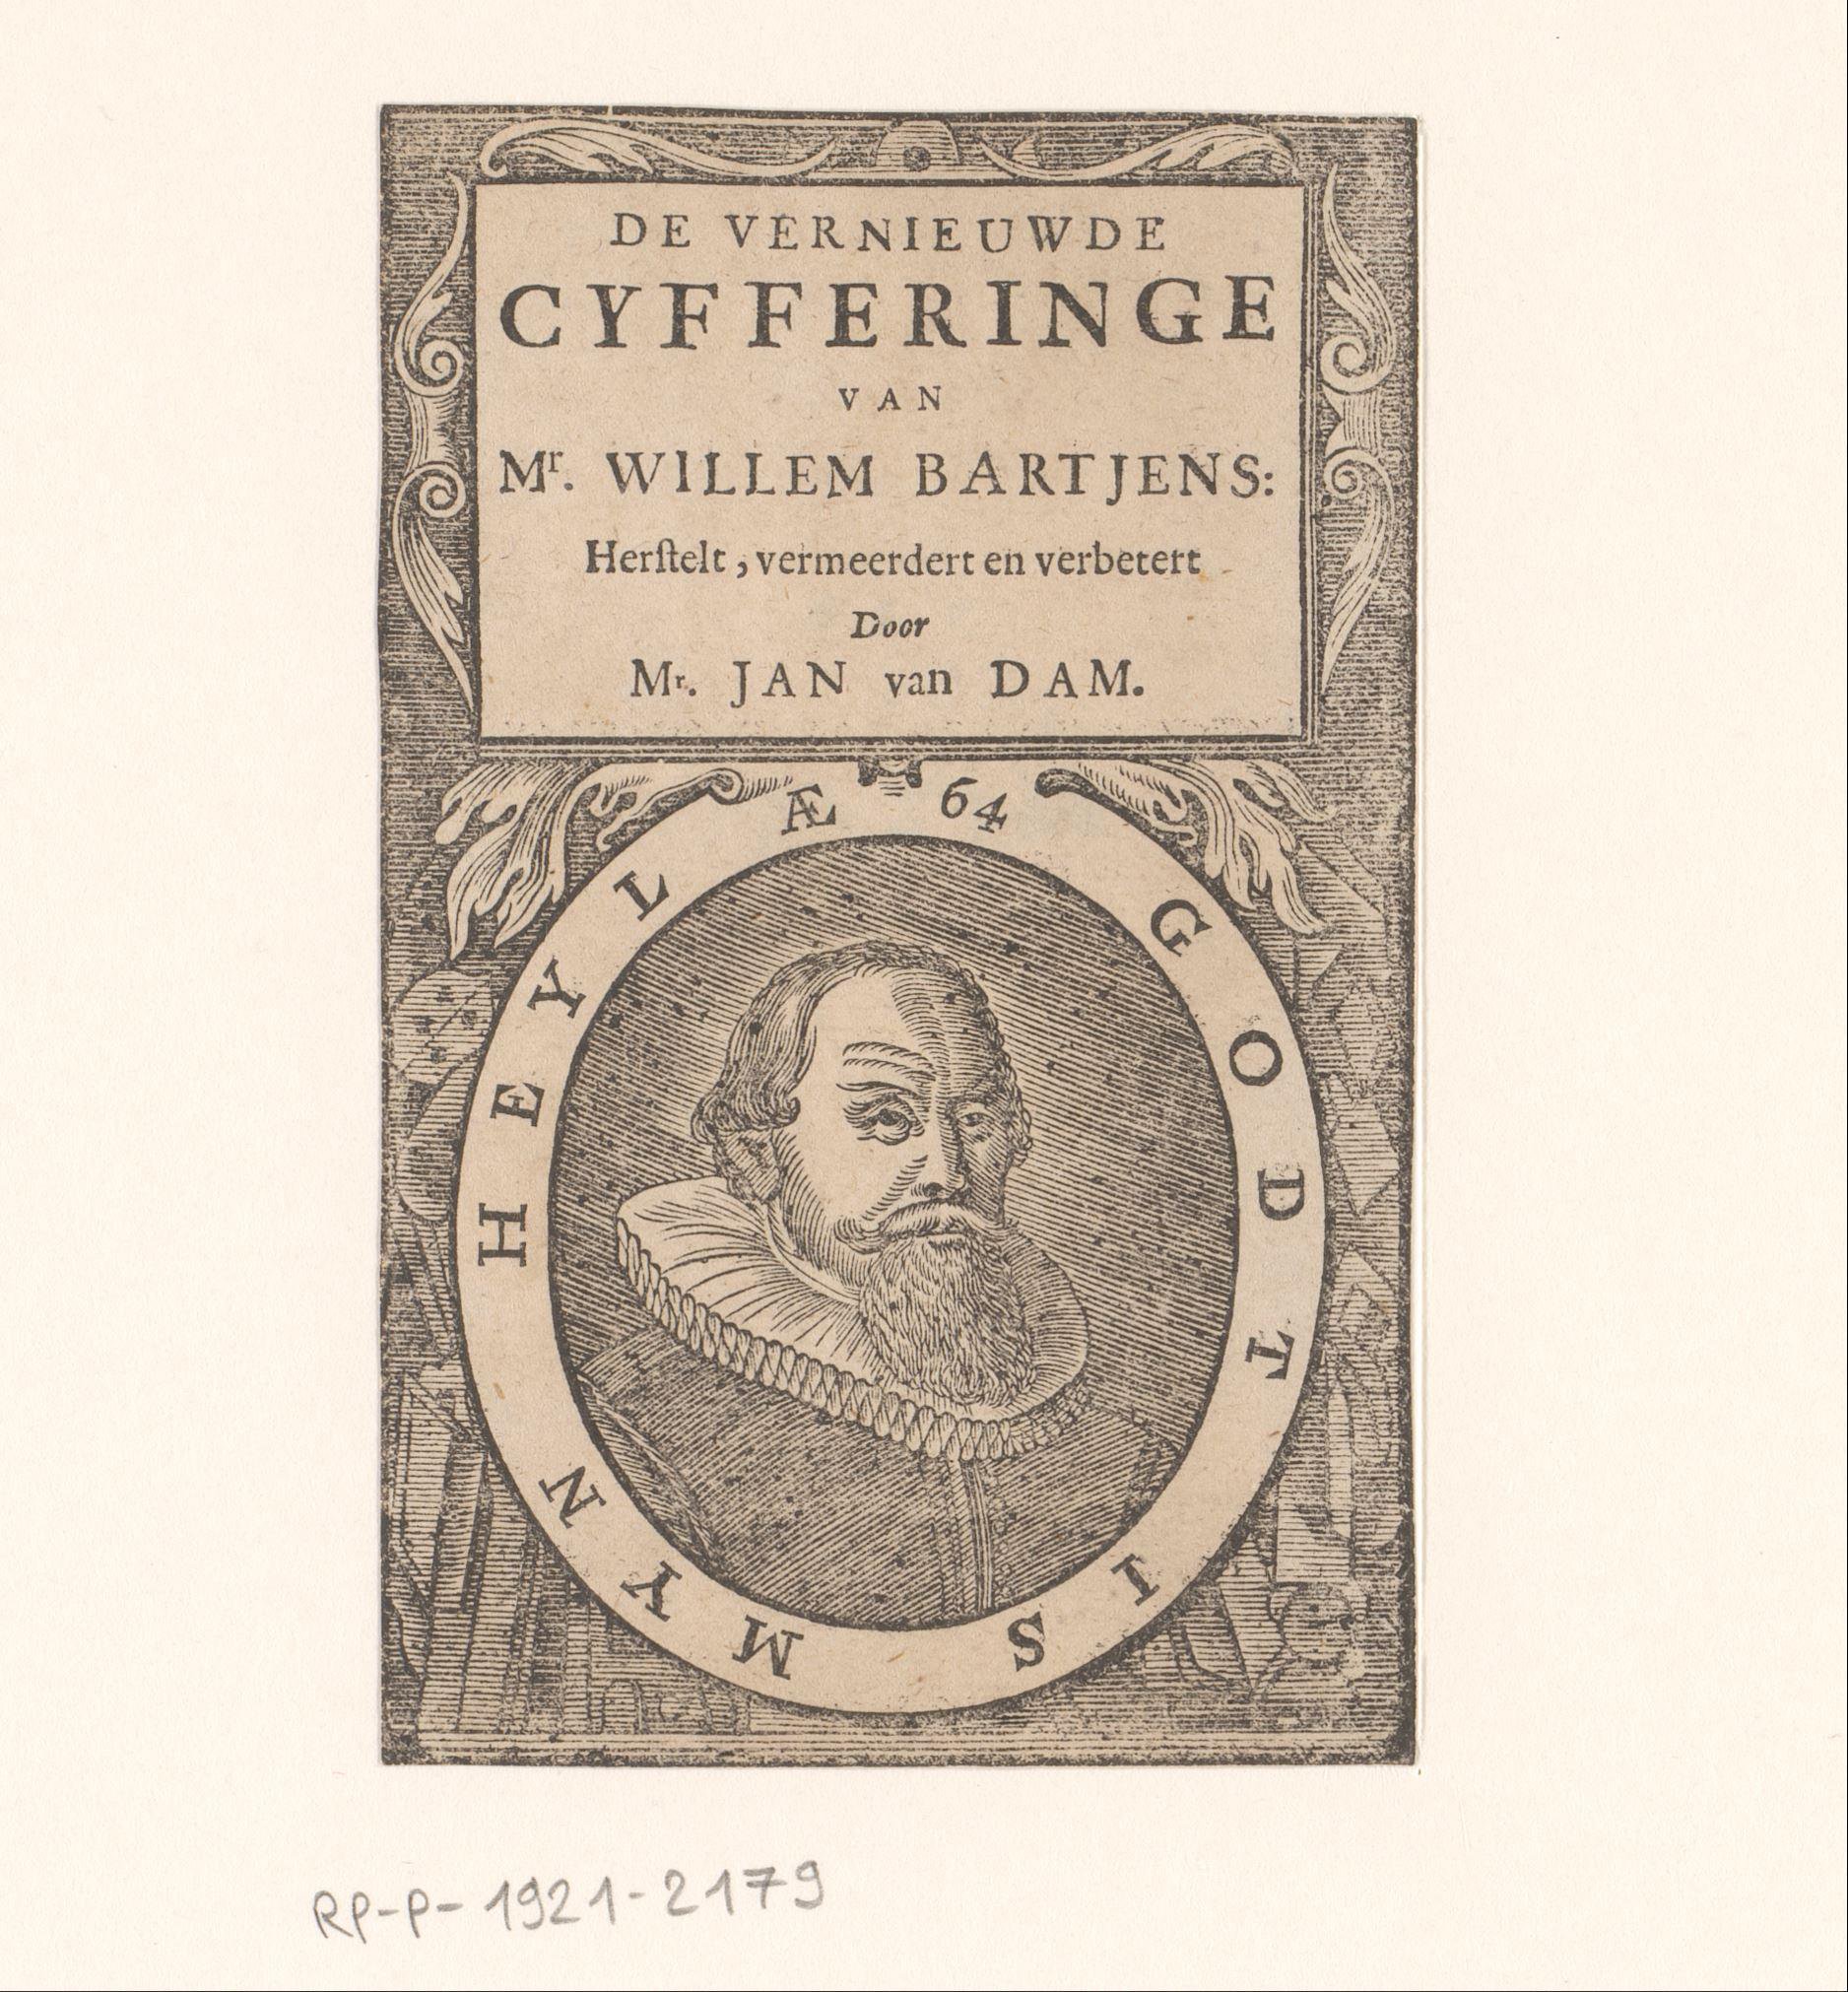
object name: print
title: Titelpagina voor: Willem Bartjens, De vernieuwde Cyfferinge (...), s.a.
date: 1750-1800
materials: paper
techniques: woodcut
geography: northern netherlands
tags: amsterdam, historical persons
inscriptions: collector's mark: Lugt 2233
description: Titelpagina voor: Bartjens, Willem. De vernieuwde Cyfferinge van Mr. Willem Bartjens (...) Herstelt, vermeerdert en verbetert door Mr. Jan van Dam (...). Amsterdam: Adam Meyer, s.a. Mogelijk ook gebruikt voor andere edities.